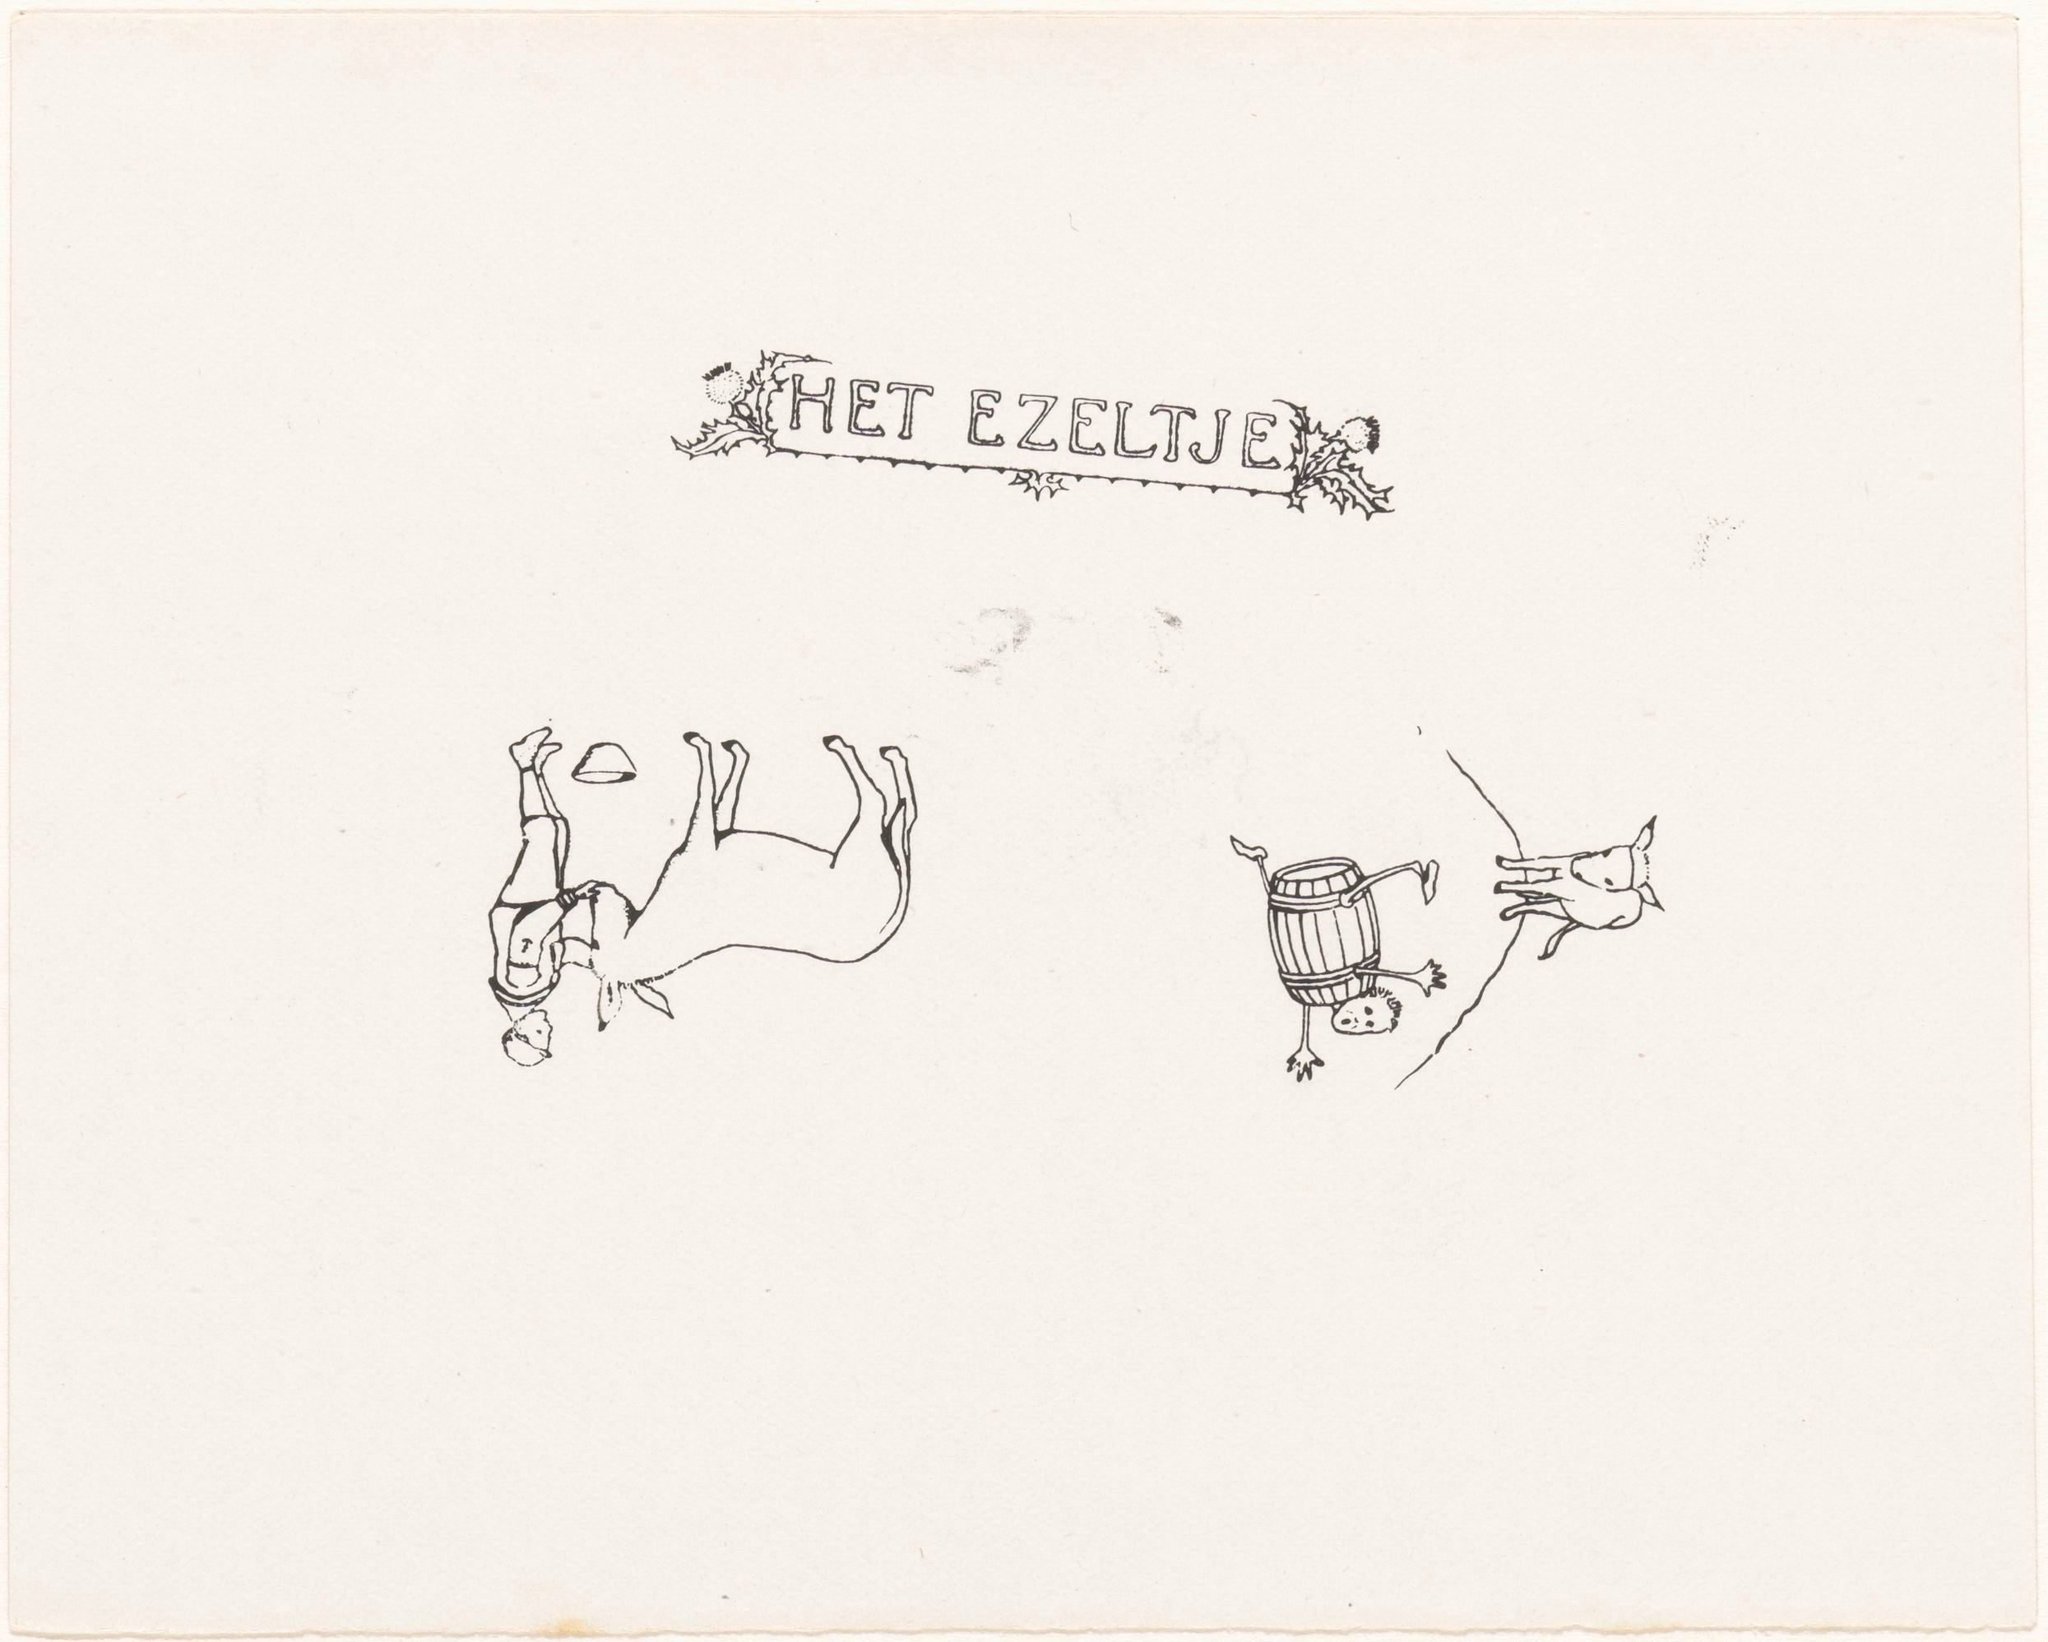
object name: print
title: Twee voorstellingen met een jongen en een ezel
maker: julie de graag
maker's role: draughtsman, print maker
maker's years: 1877-1924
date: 1887-1924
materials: paper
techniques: line block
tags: ass, donkey, boy (child between toddler and youth)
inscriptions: collector's mark: Lugt 2228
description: Bovenaan de tekst 'HET EZELTJE', mogelijk een verwijzing naar de titel van het boek waar de voorstellingen voor gemaakt zijn, omgeven door distels. Links een jongen die een ezel voert uit een schaal. Rechts een jongen die in een ton een heuvel afrolt terwijl hij wordt bekeken door een ezel.